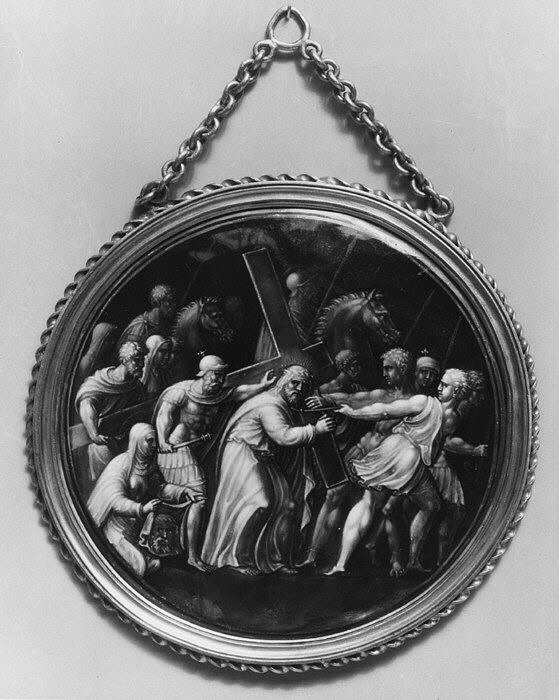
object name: medallion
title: Christ Bearing the Cross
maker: jean ii pénicaud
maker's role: enameler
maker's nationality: french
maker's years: 1524-1554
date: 1534-1566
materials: copper, enamel, gilt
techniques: painting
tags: horses,christ,cross,crowd